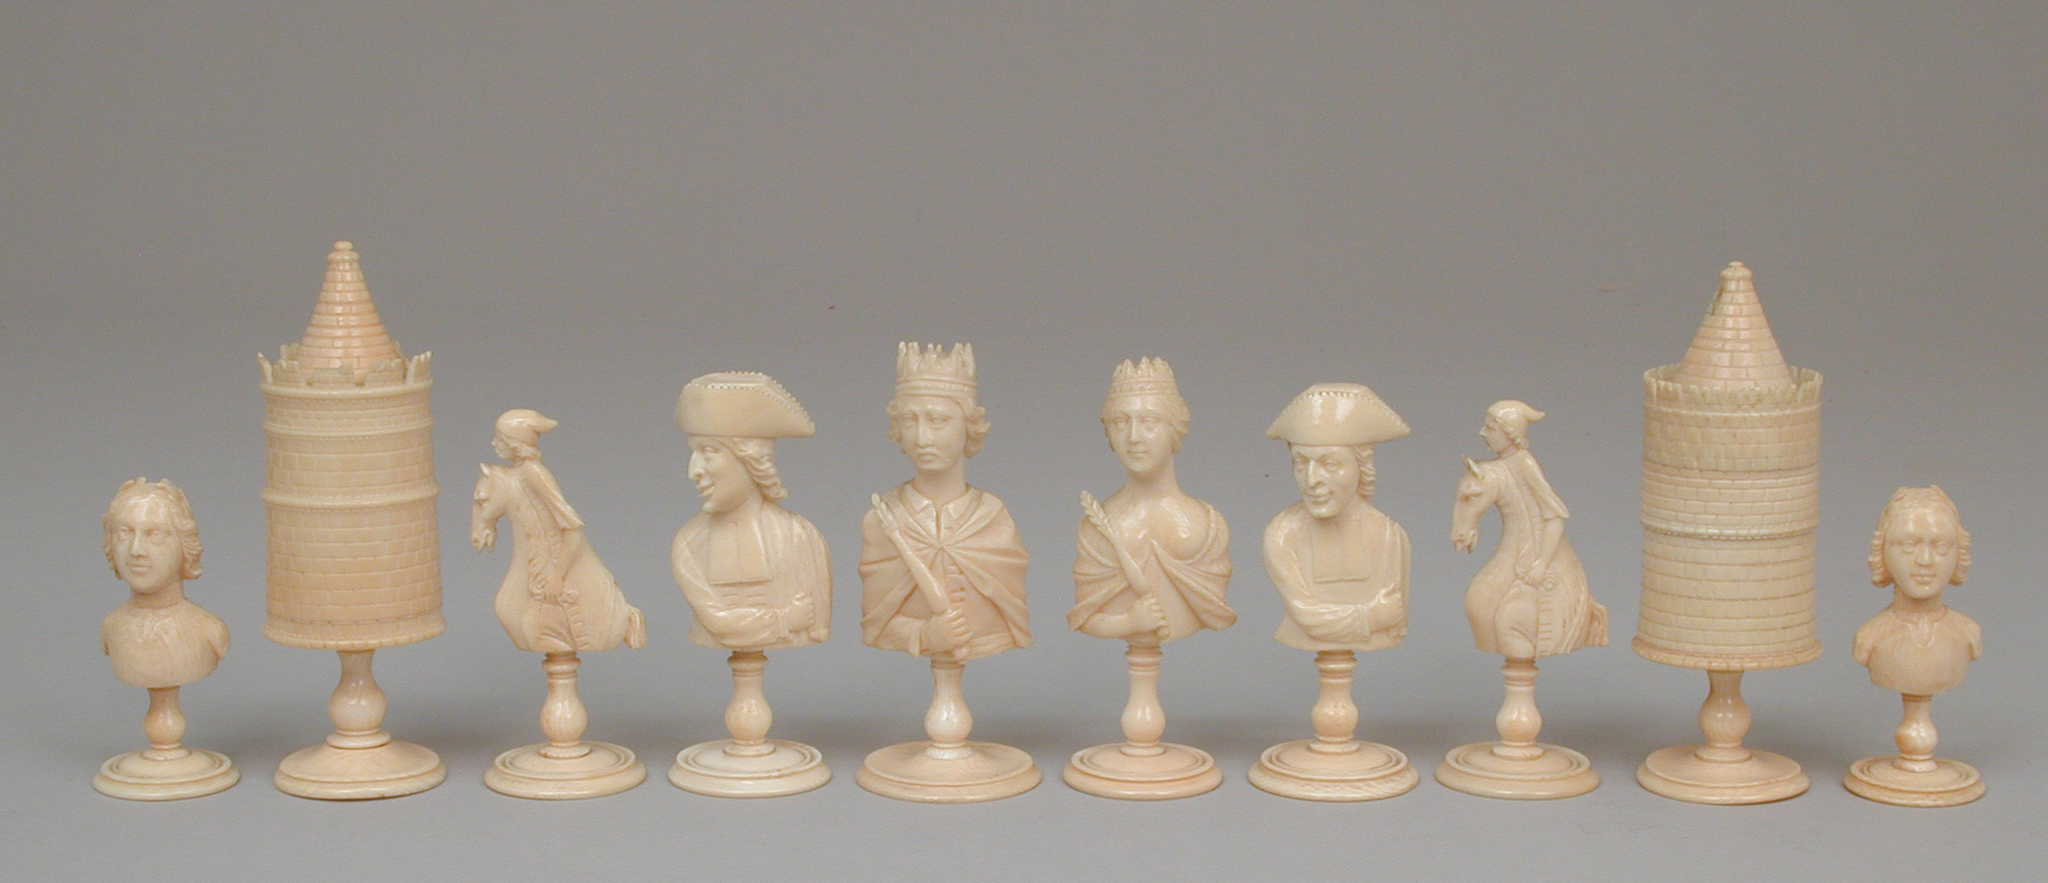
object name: chessman and box board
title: Frenchmen and African chessmen (32) and box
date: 1867-1900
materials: brass, ivory, wood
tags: chess,games